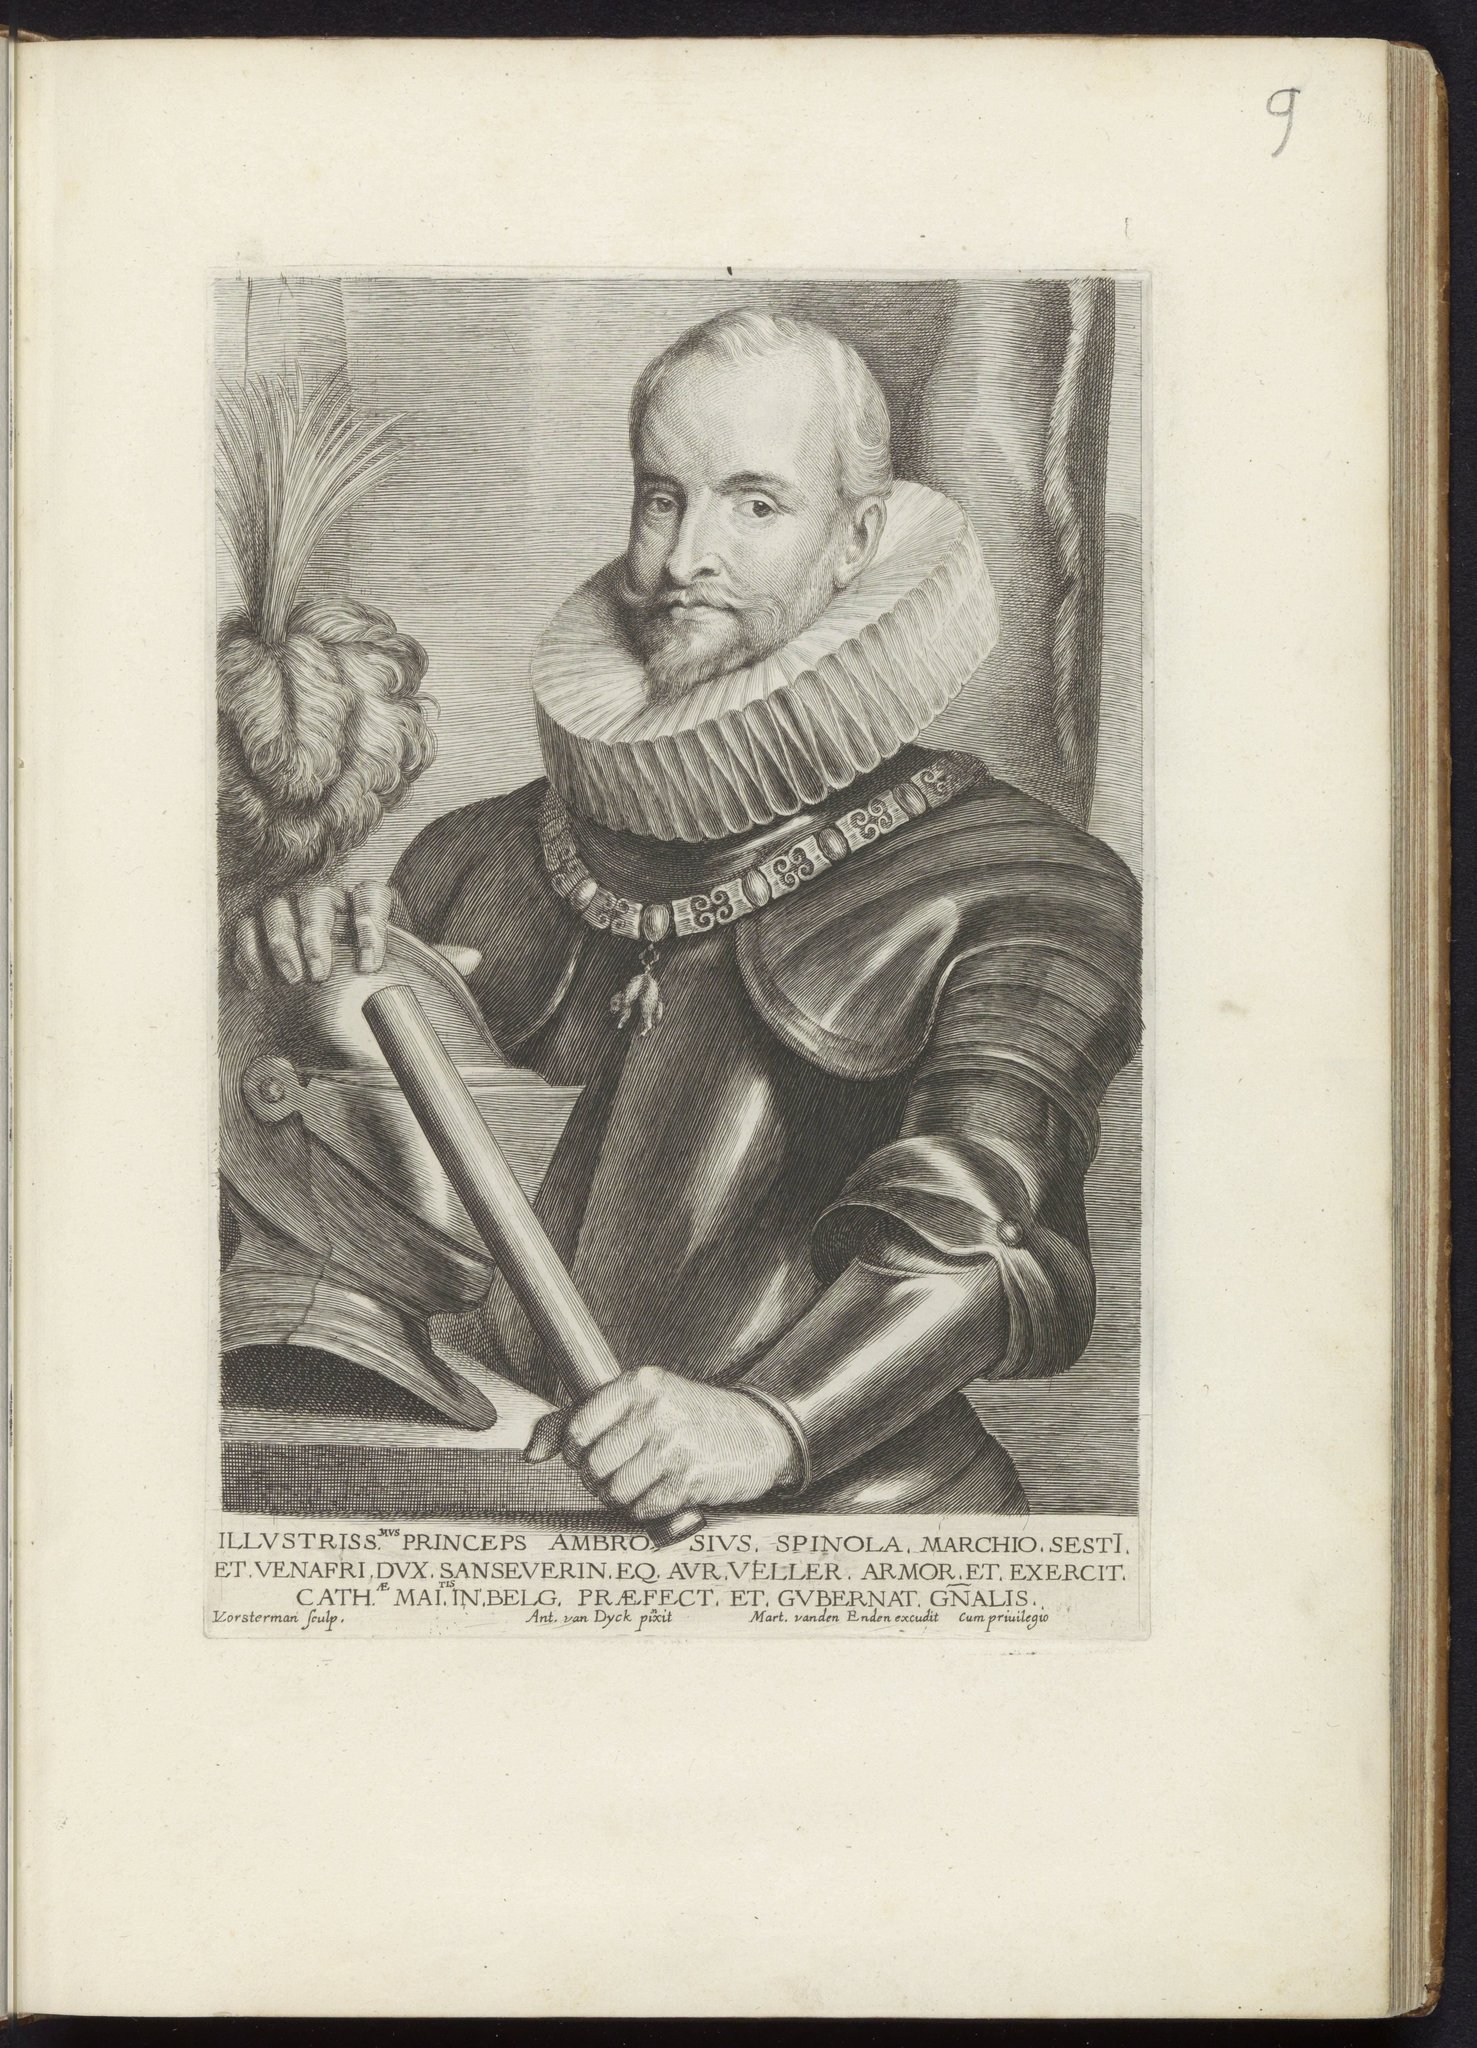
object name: print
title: Iconographie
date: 1630-1641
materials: paper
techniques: engraving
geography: antwerp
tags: helmet, armour, knighthood order of the golden fleece, baton of general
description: Portret van Ambrogio Spinola, markies de los Balbases, opperbevelhebber van de Spaanse troepen in de Zuidelijke Nederlanden. Zijn rechterhand rustend op helm, commandostaf in linkerhand. Om zijn hals een ketting met het teken van de Orde van het Gulden Vlies. Deze prent maakt deel uit van een album.